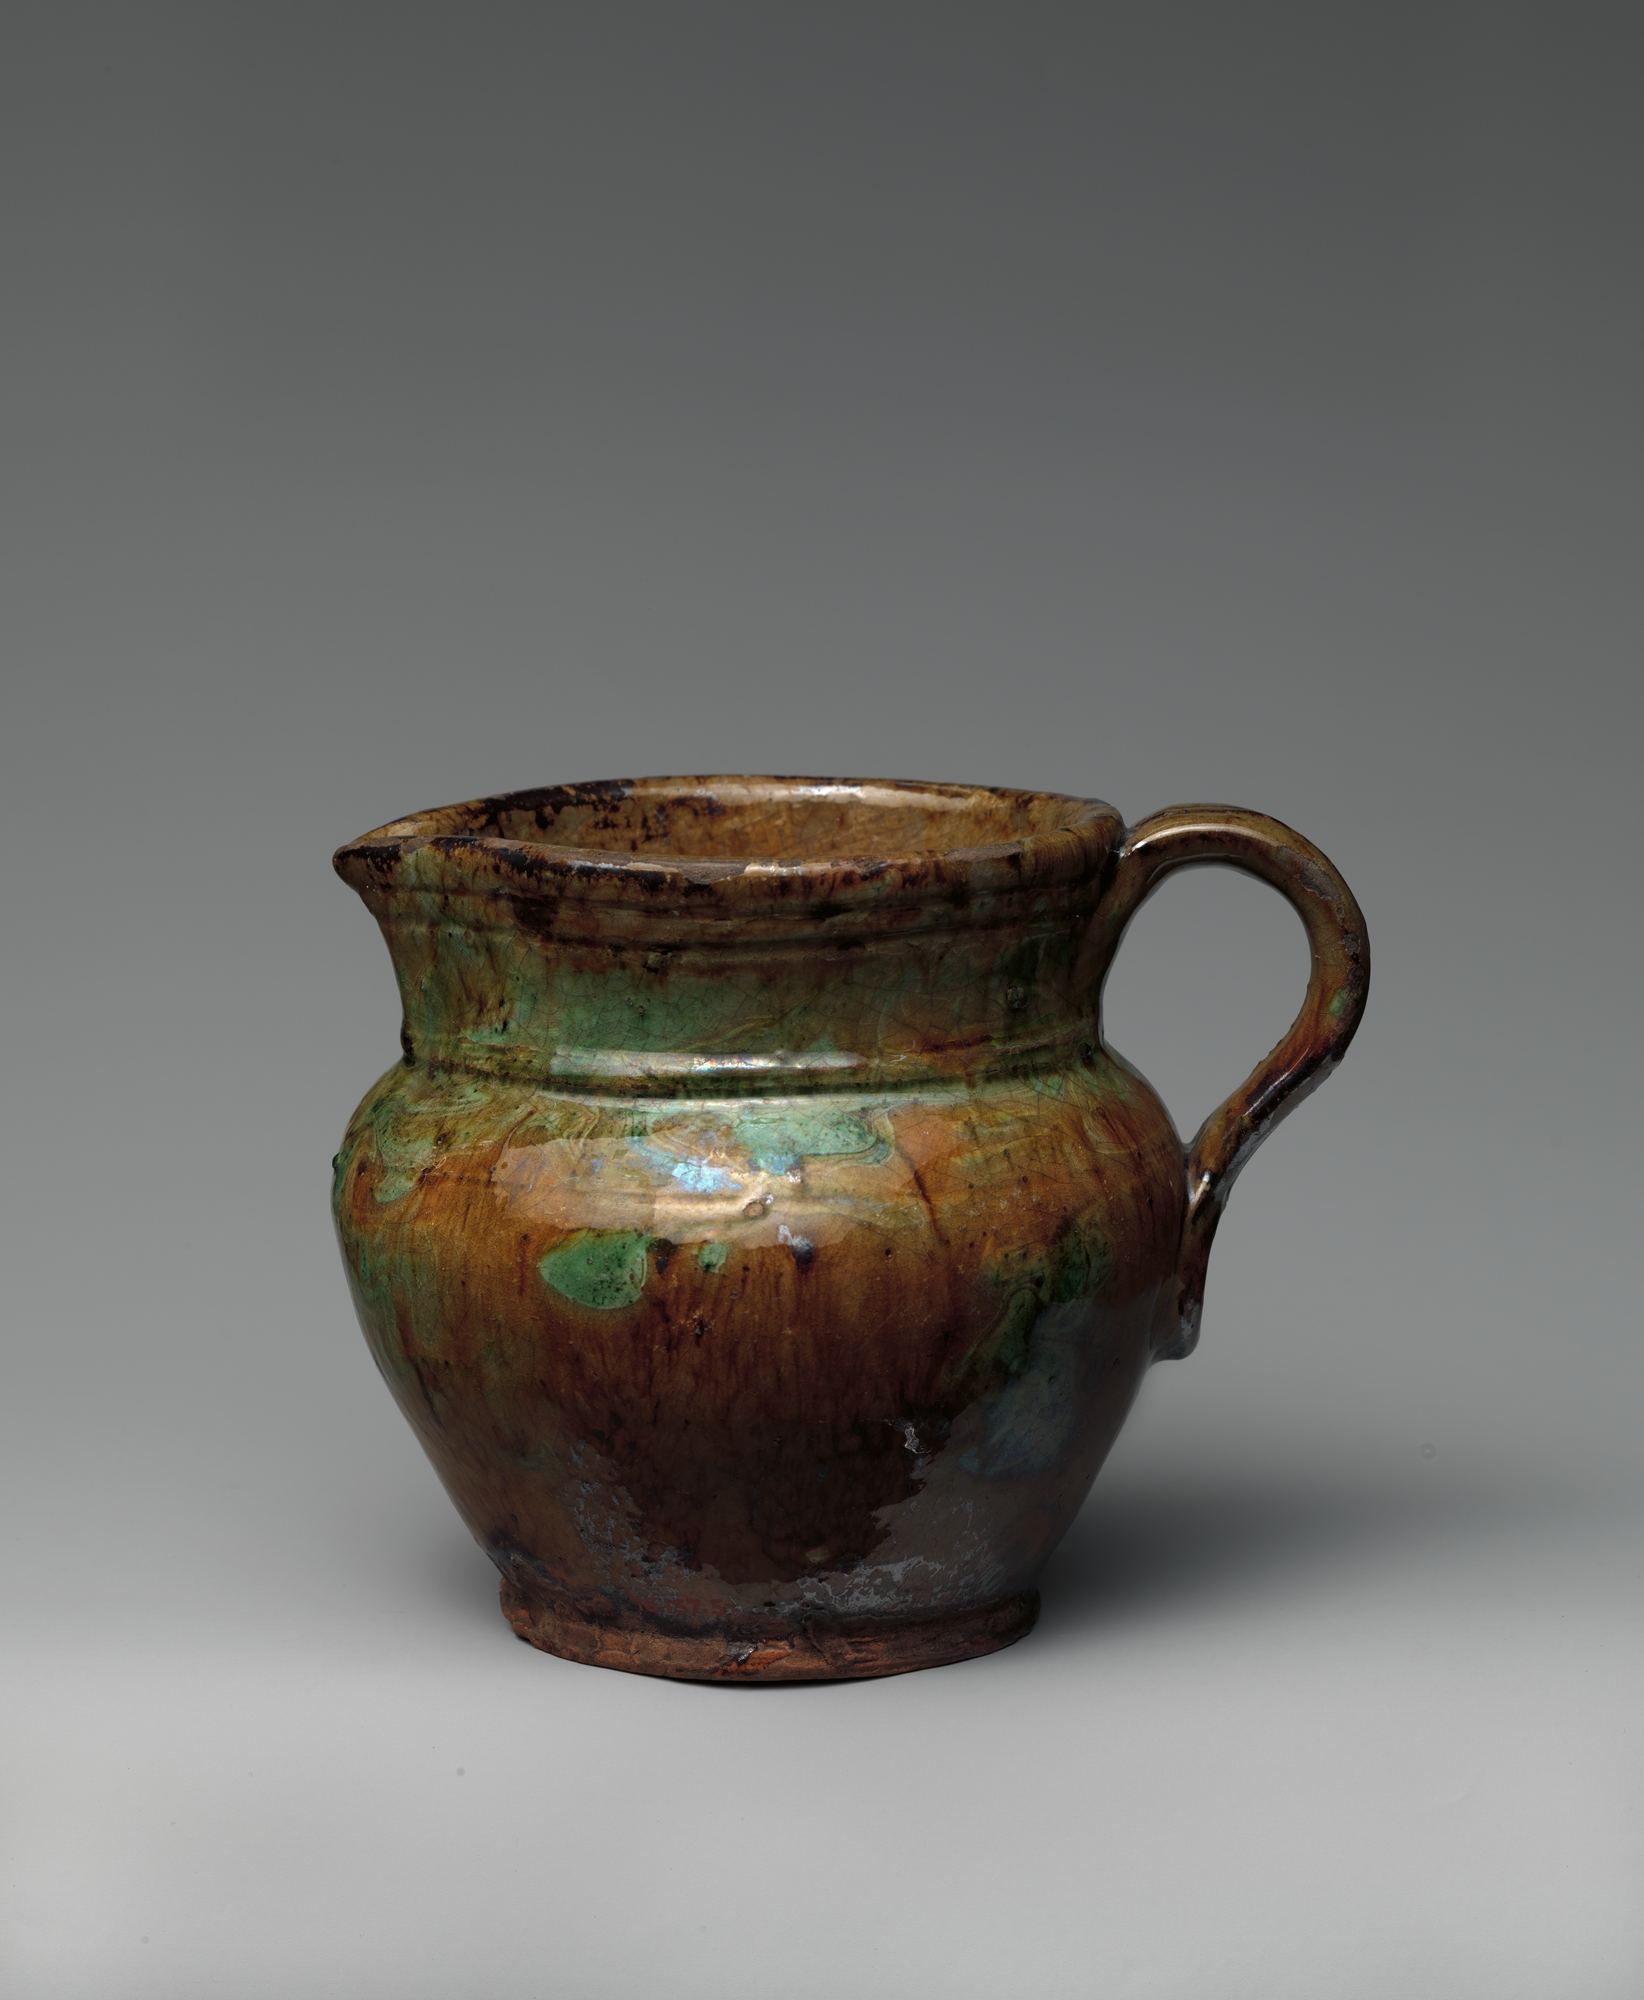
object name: pitcher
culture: american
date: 1800-1900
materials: earthenware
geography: united states